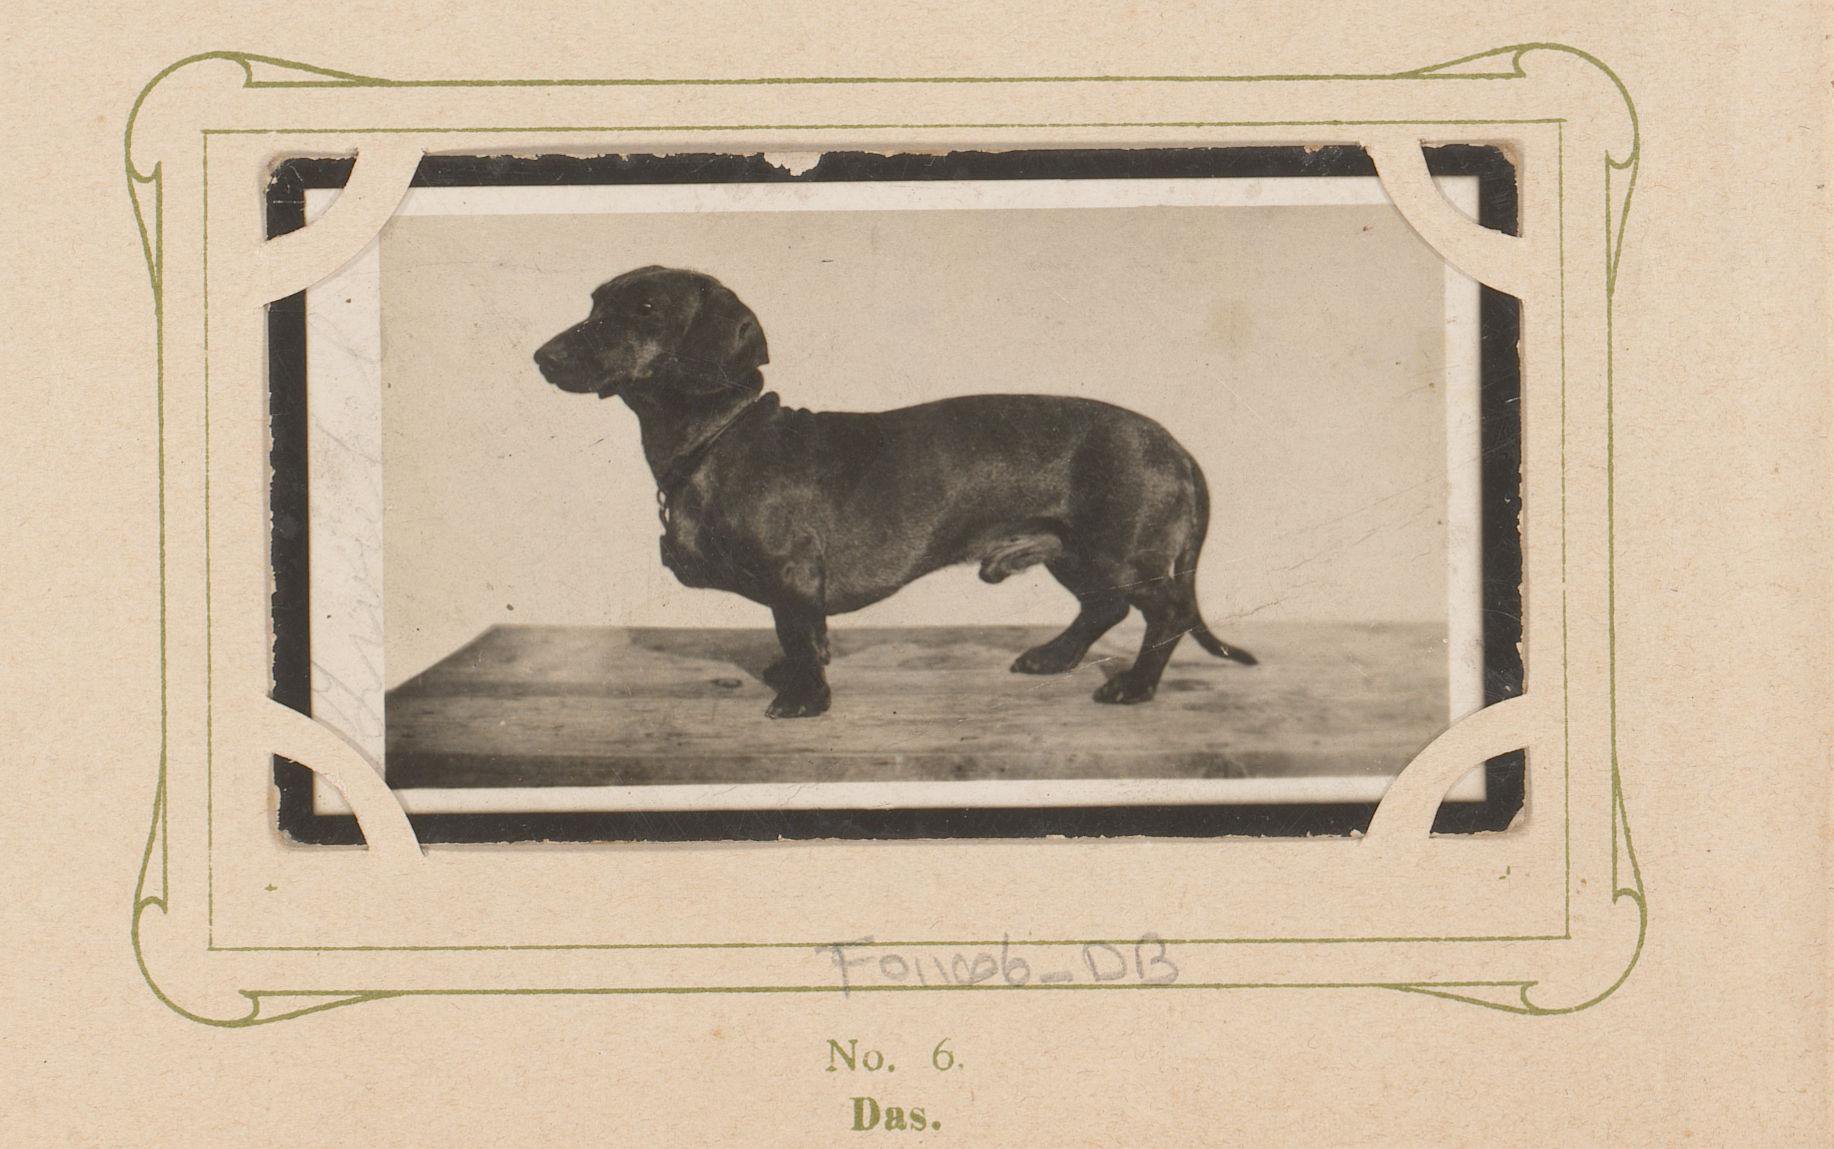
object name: album leaf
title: Teckel of dashond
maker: Anonymous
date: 1904-1905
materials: photographic support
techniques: gelatin silver print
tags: dog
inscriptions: inscription: ‘No. 6./ Das.’